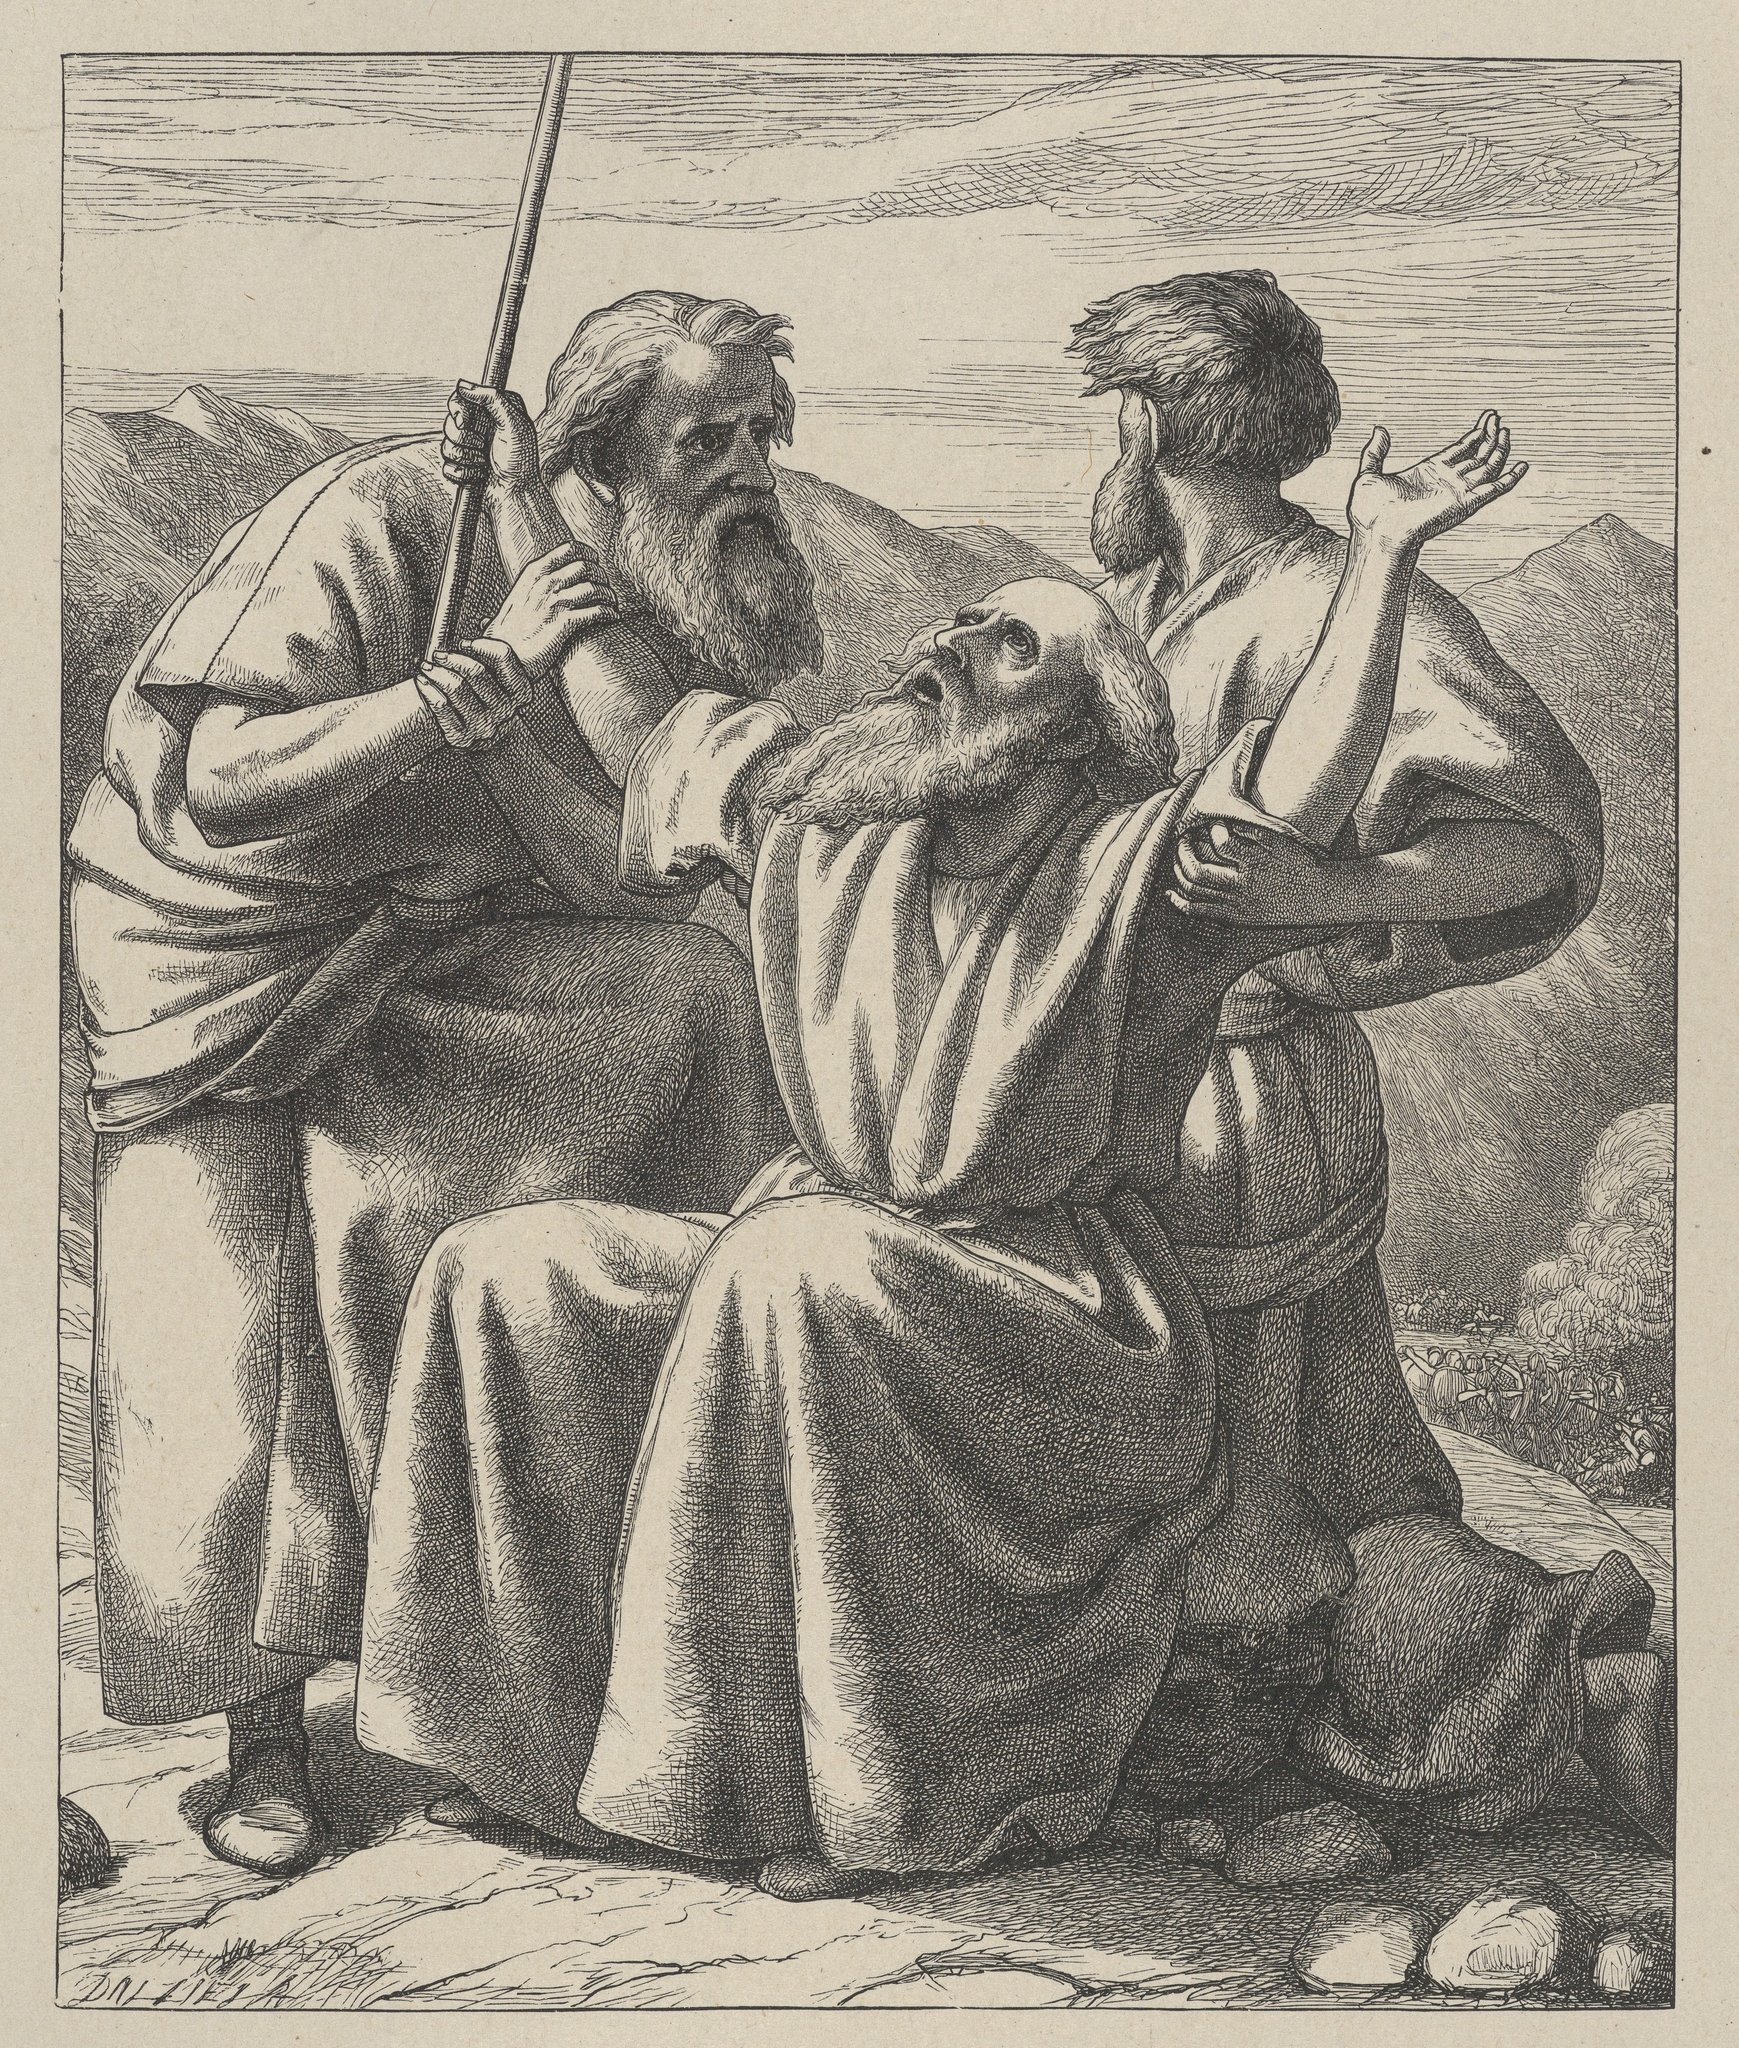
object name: print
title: Moses' Hands Held Up, from "Dalziels' Bible Gallery"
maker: frederick richard pickersgill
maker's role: artist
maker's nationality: british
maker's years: 1820-1900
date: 1865-1881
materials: paper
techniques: engraving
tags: men,moses